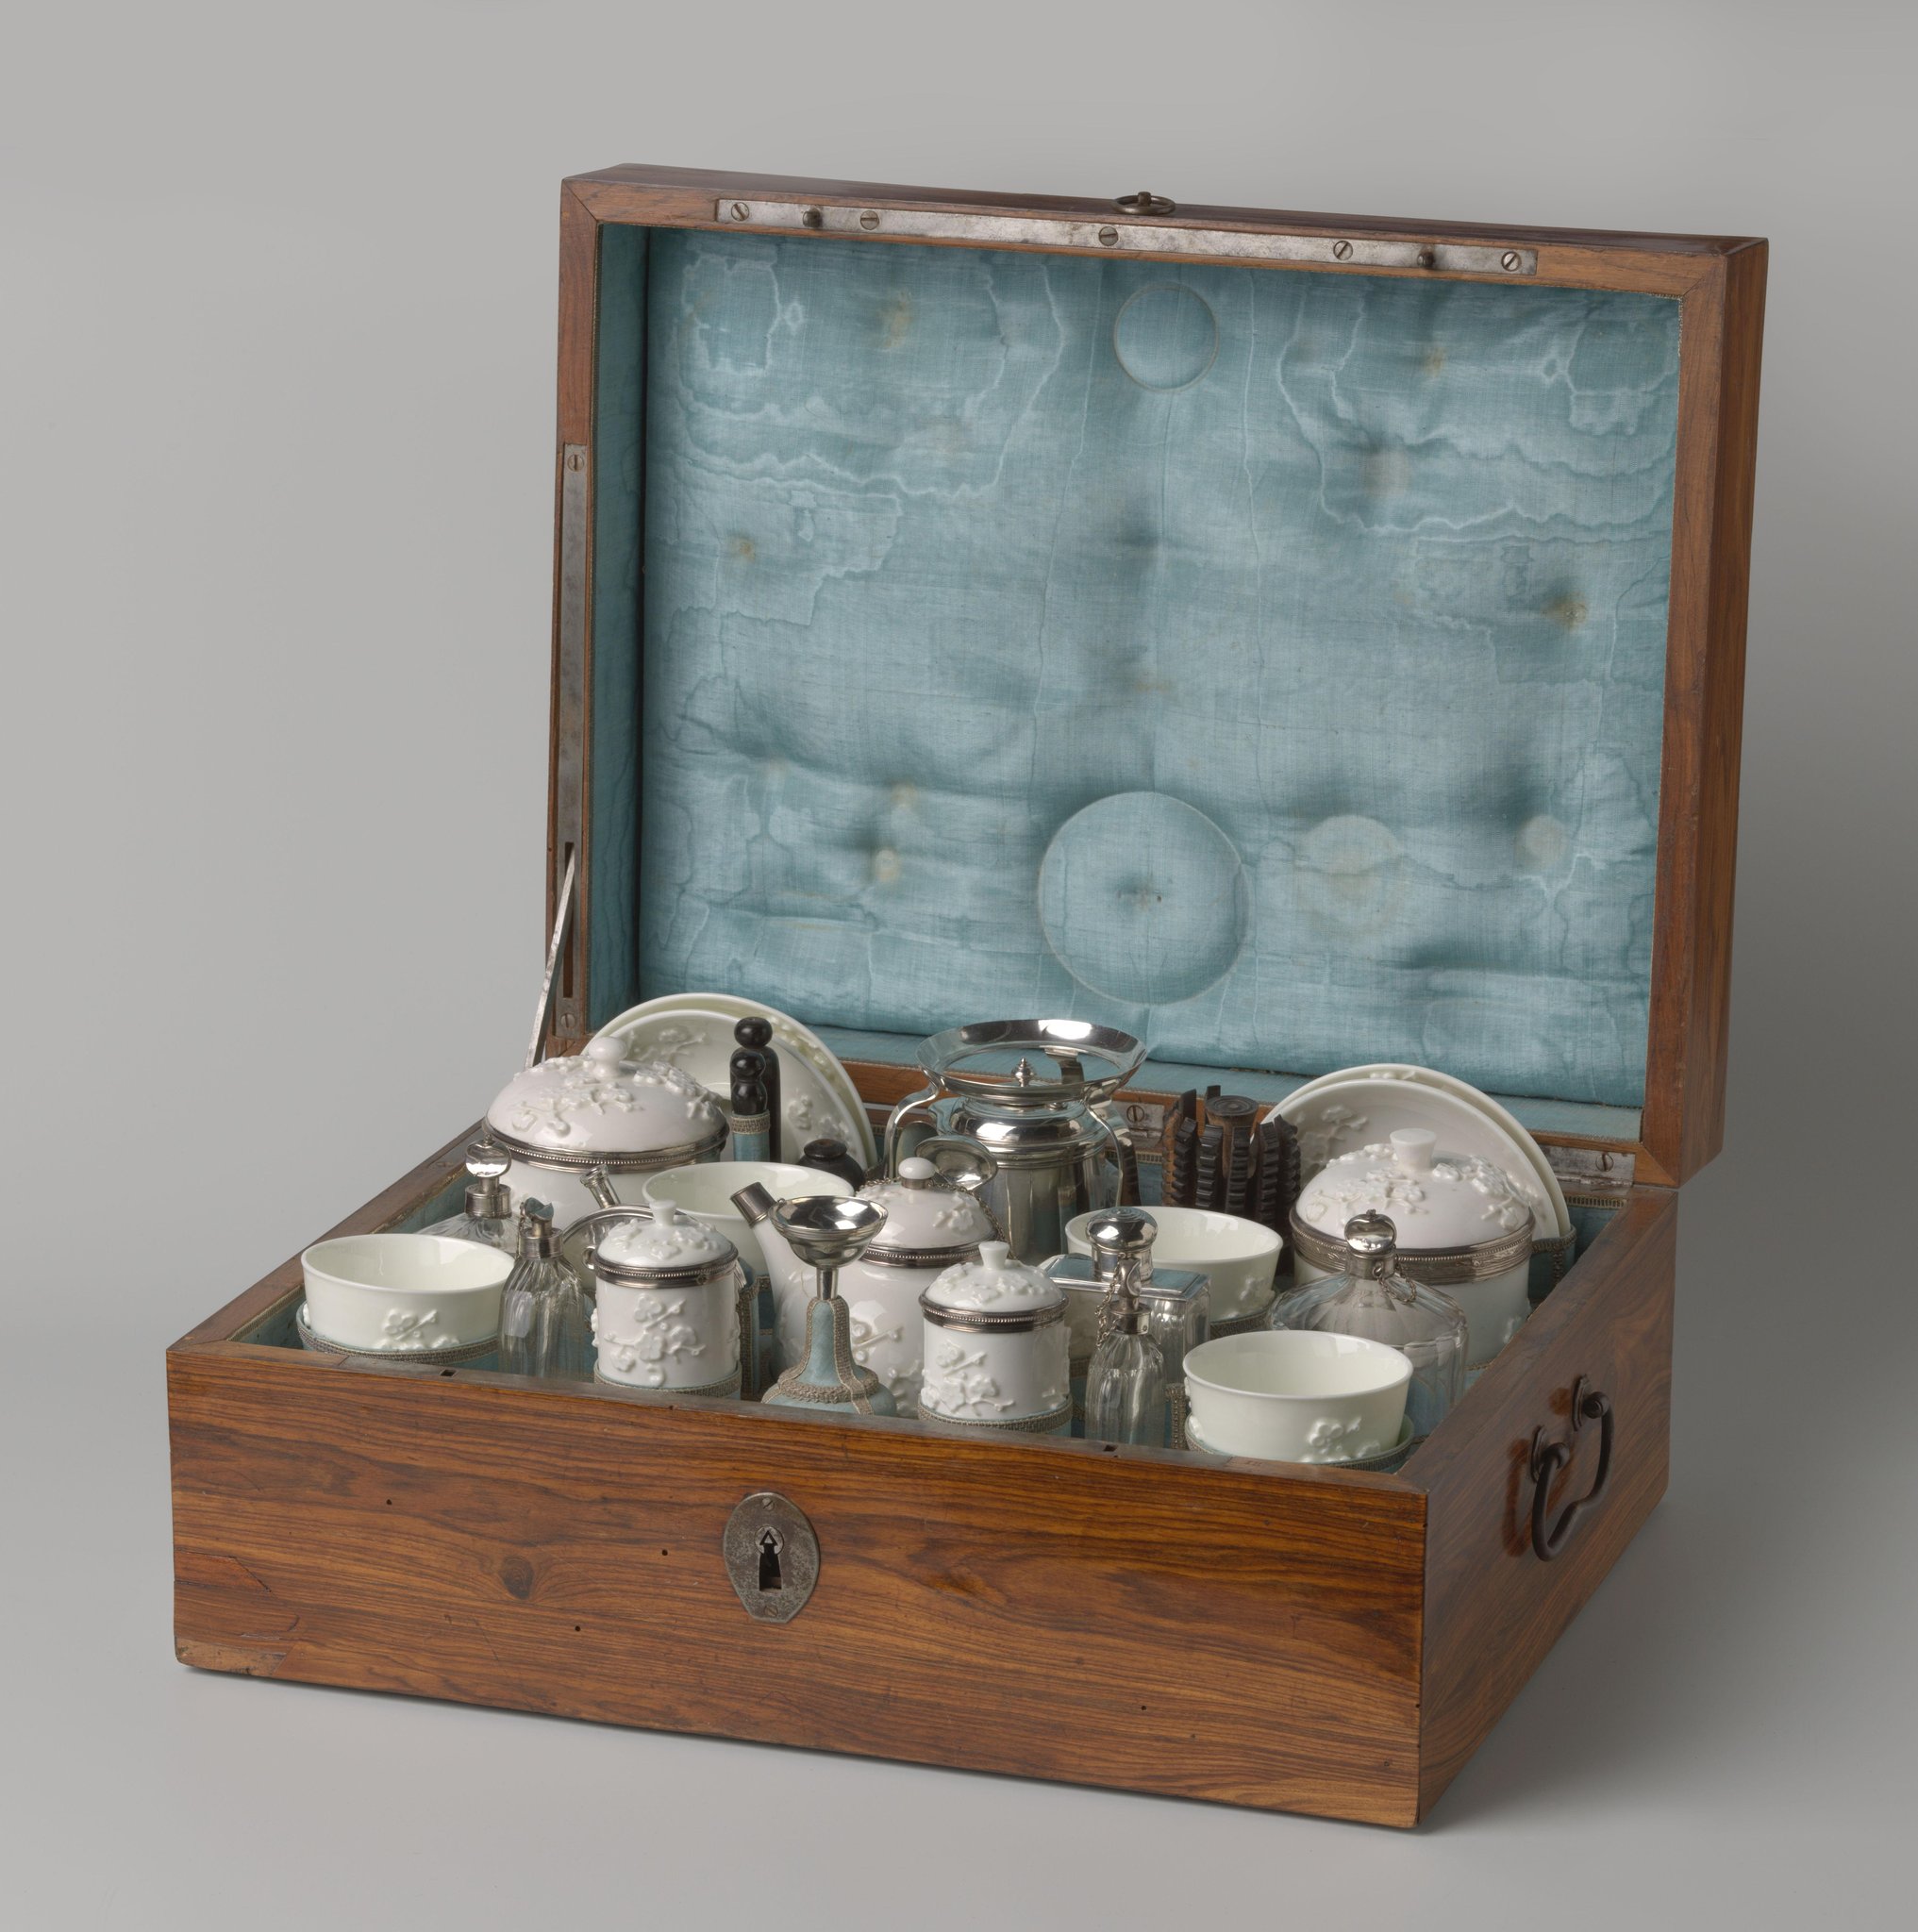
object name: reisnecessaire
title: Reisnecessaire van rozenhout met porselein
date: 1746-1747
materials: crystal, wood, silk, silver, soft paste porcelain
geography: paris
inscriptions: maker's mark: ‘LG’, import mark: ‘zwijntje’, maker's mark: ‘PEB’, date letter: ‘F en G’, duty mark: ‘gekroonde A’, maker's mark: ‘PJA’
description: De kist is gemaakt van ingelegd kingwood hout (parqueterie) en van binnen bekleed met turkoois moire zijde. In de rand van de houten kist staan de letters IB gegraveerd. Twee koperen hengsels en een slot met sleutel. Het witte porselein uit St. Cloud heeft een reliëf met bloemen. Inhoud: een zilveren chocolade kan met schroevende ebbenhouten handvat en houten roerspaan, gekeurd met meesterteken Pierre-Aimé Joubert en gekroonde jaarletter G en trembleersteek. Een zilveren komfoor met schroevende ebbenhouten handvat, meesterteken van Pierre-Aimé Joubert, trembleerstreek, zwijntje jaarletter F. De deksel van de komfoor heeft meesterteken PJA in gecontourneerde vorm, gekroonde jaarletter G. Een rechthoekig zilveren theebusje met schroefdop, gekeurd meesterteken PJA in gecontourneerde vorm, jaarletter F en trembleersteek. Een zilveren trechter, vier zilveren lepeltjes met meesterteken PB en ? in gecontourneerde vorm, jaarletter G. Een zilveren suikerschepje met meesterteken LG en ? en jaarletter G. Twee ronde kristallen en twee platte flacons met zilveren monturen en stopje aan kettinkje. St. Cloud porselein met florale decor en zilveren monturen, bestaande uit: theepot, vier kop- en schotels, twee ronde potten, twee kleine potjes.